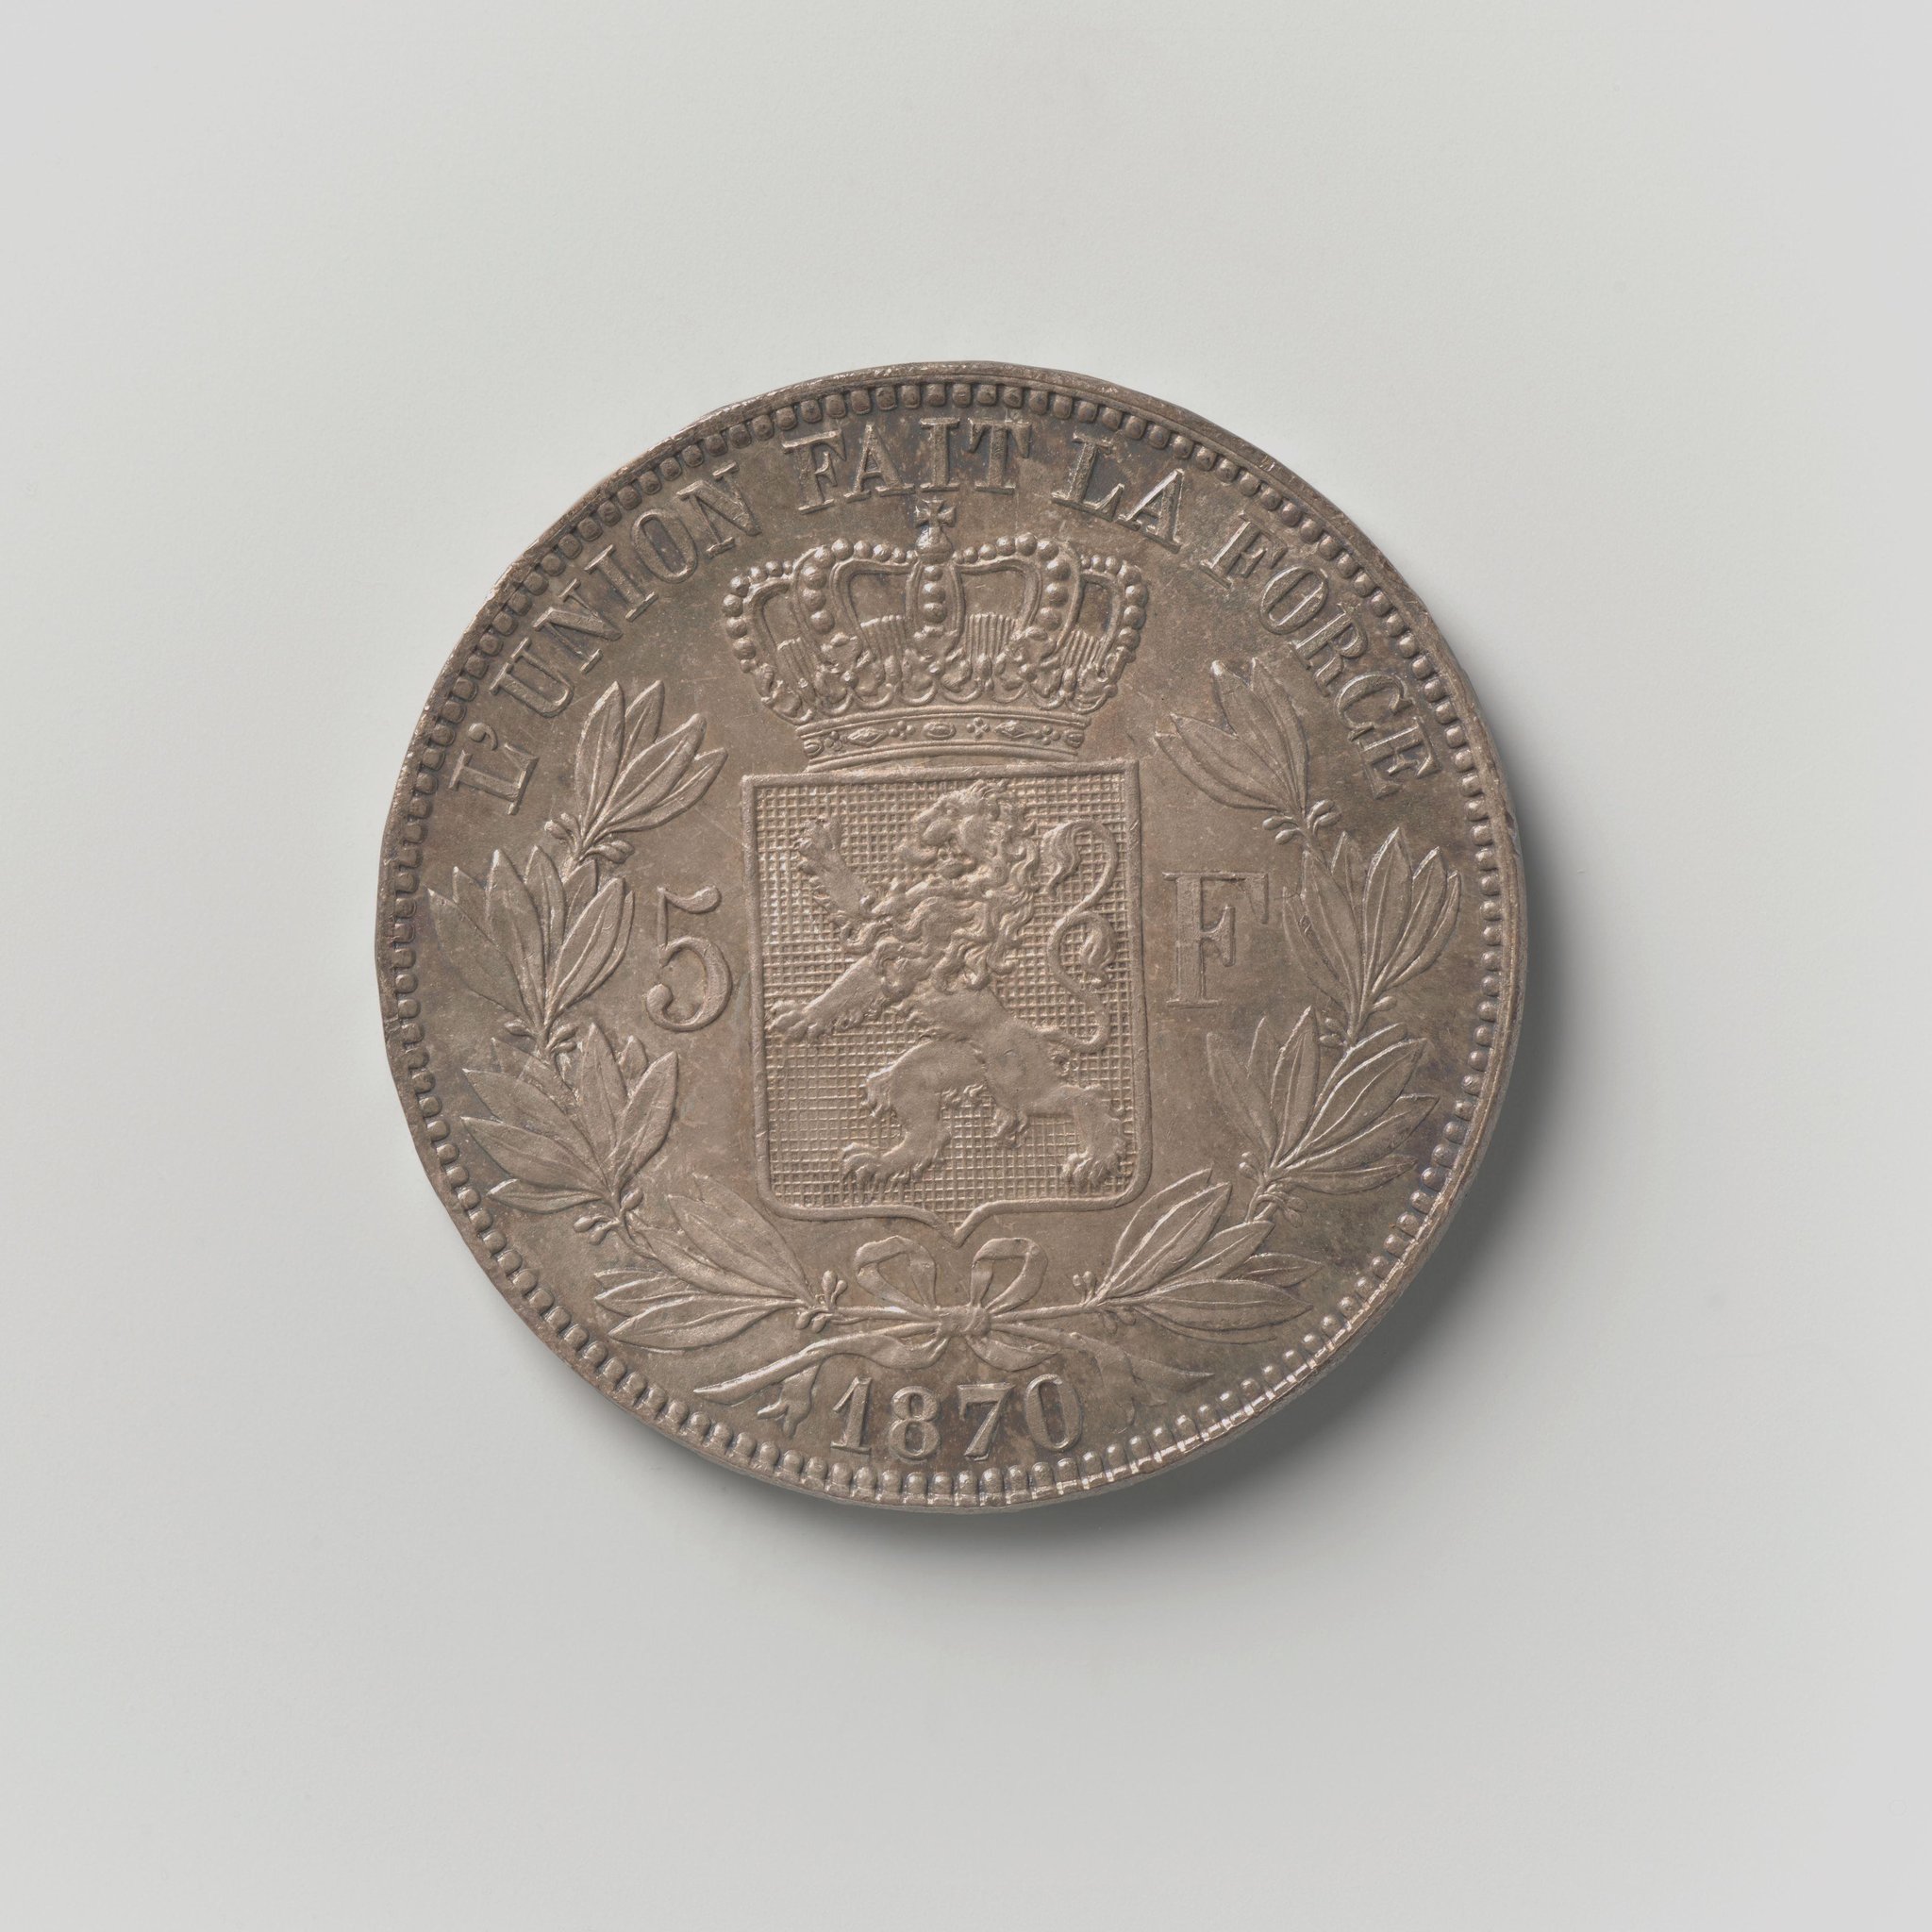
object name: coin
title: 5 francs uit België van Leopold II, 1870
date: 1870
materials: silver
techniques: striking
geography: brussels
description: Zilveren munt. Voorzijde: borstbeeld van de koning naar links. Keerzijde: binnen twee samengebonden lauwertakken tussen waarde-aanduiding gekroond wapenschild. Jaartal onderaan. Opliggend randschrift.